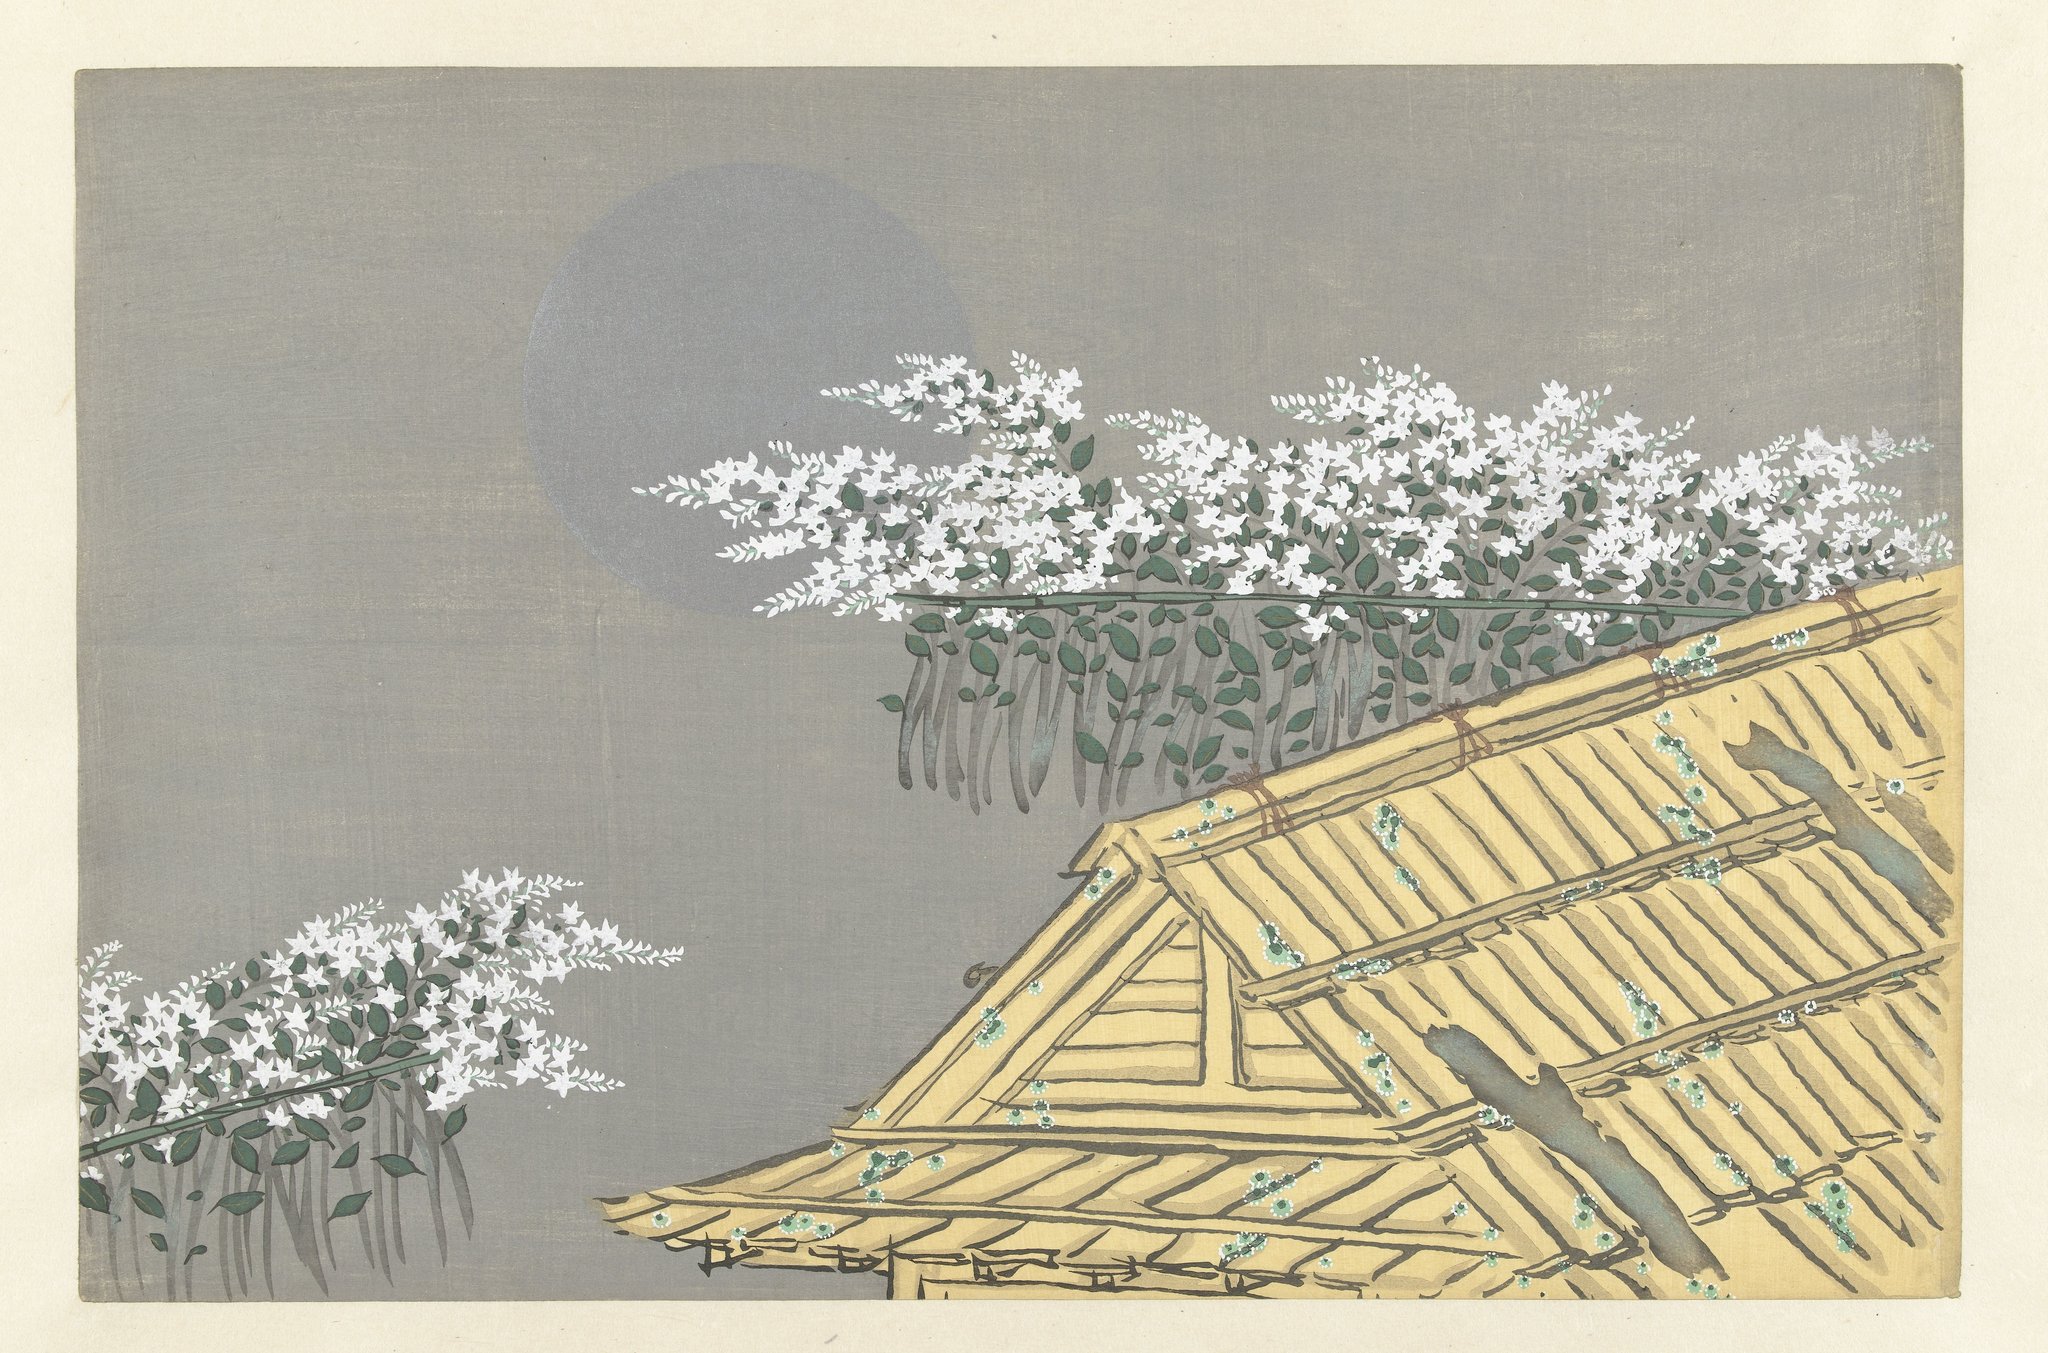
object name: print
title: Witte bloemen bij huis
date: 1909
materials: paper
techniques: woodcut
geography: kyoto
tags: flowers, roof (of house or building), plants and herbs: reed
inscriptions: collector's mark: Lugt 2228, collector's mark: Lugt 2760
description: Wit bloeiend raapzaad bij houten huis, met zilverkleurige volle maan.